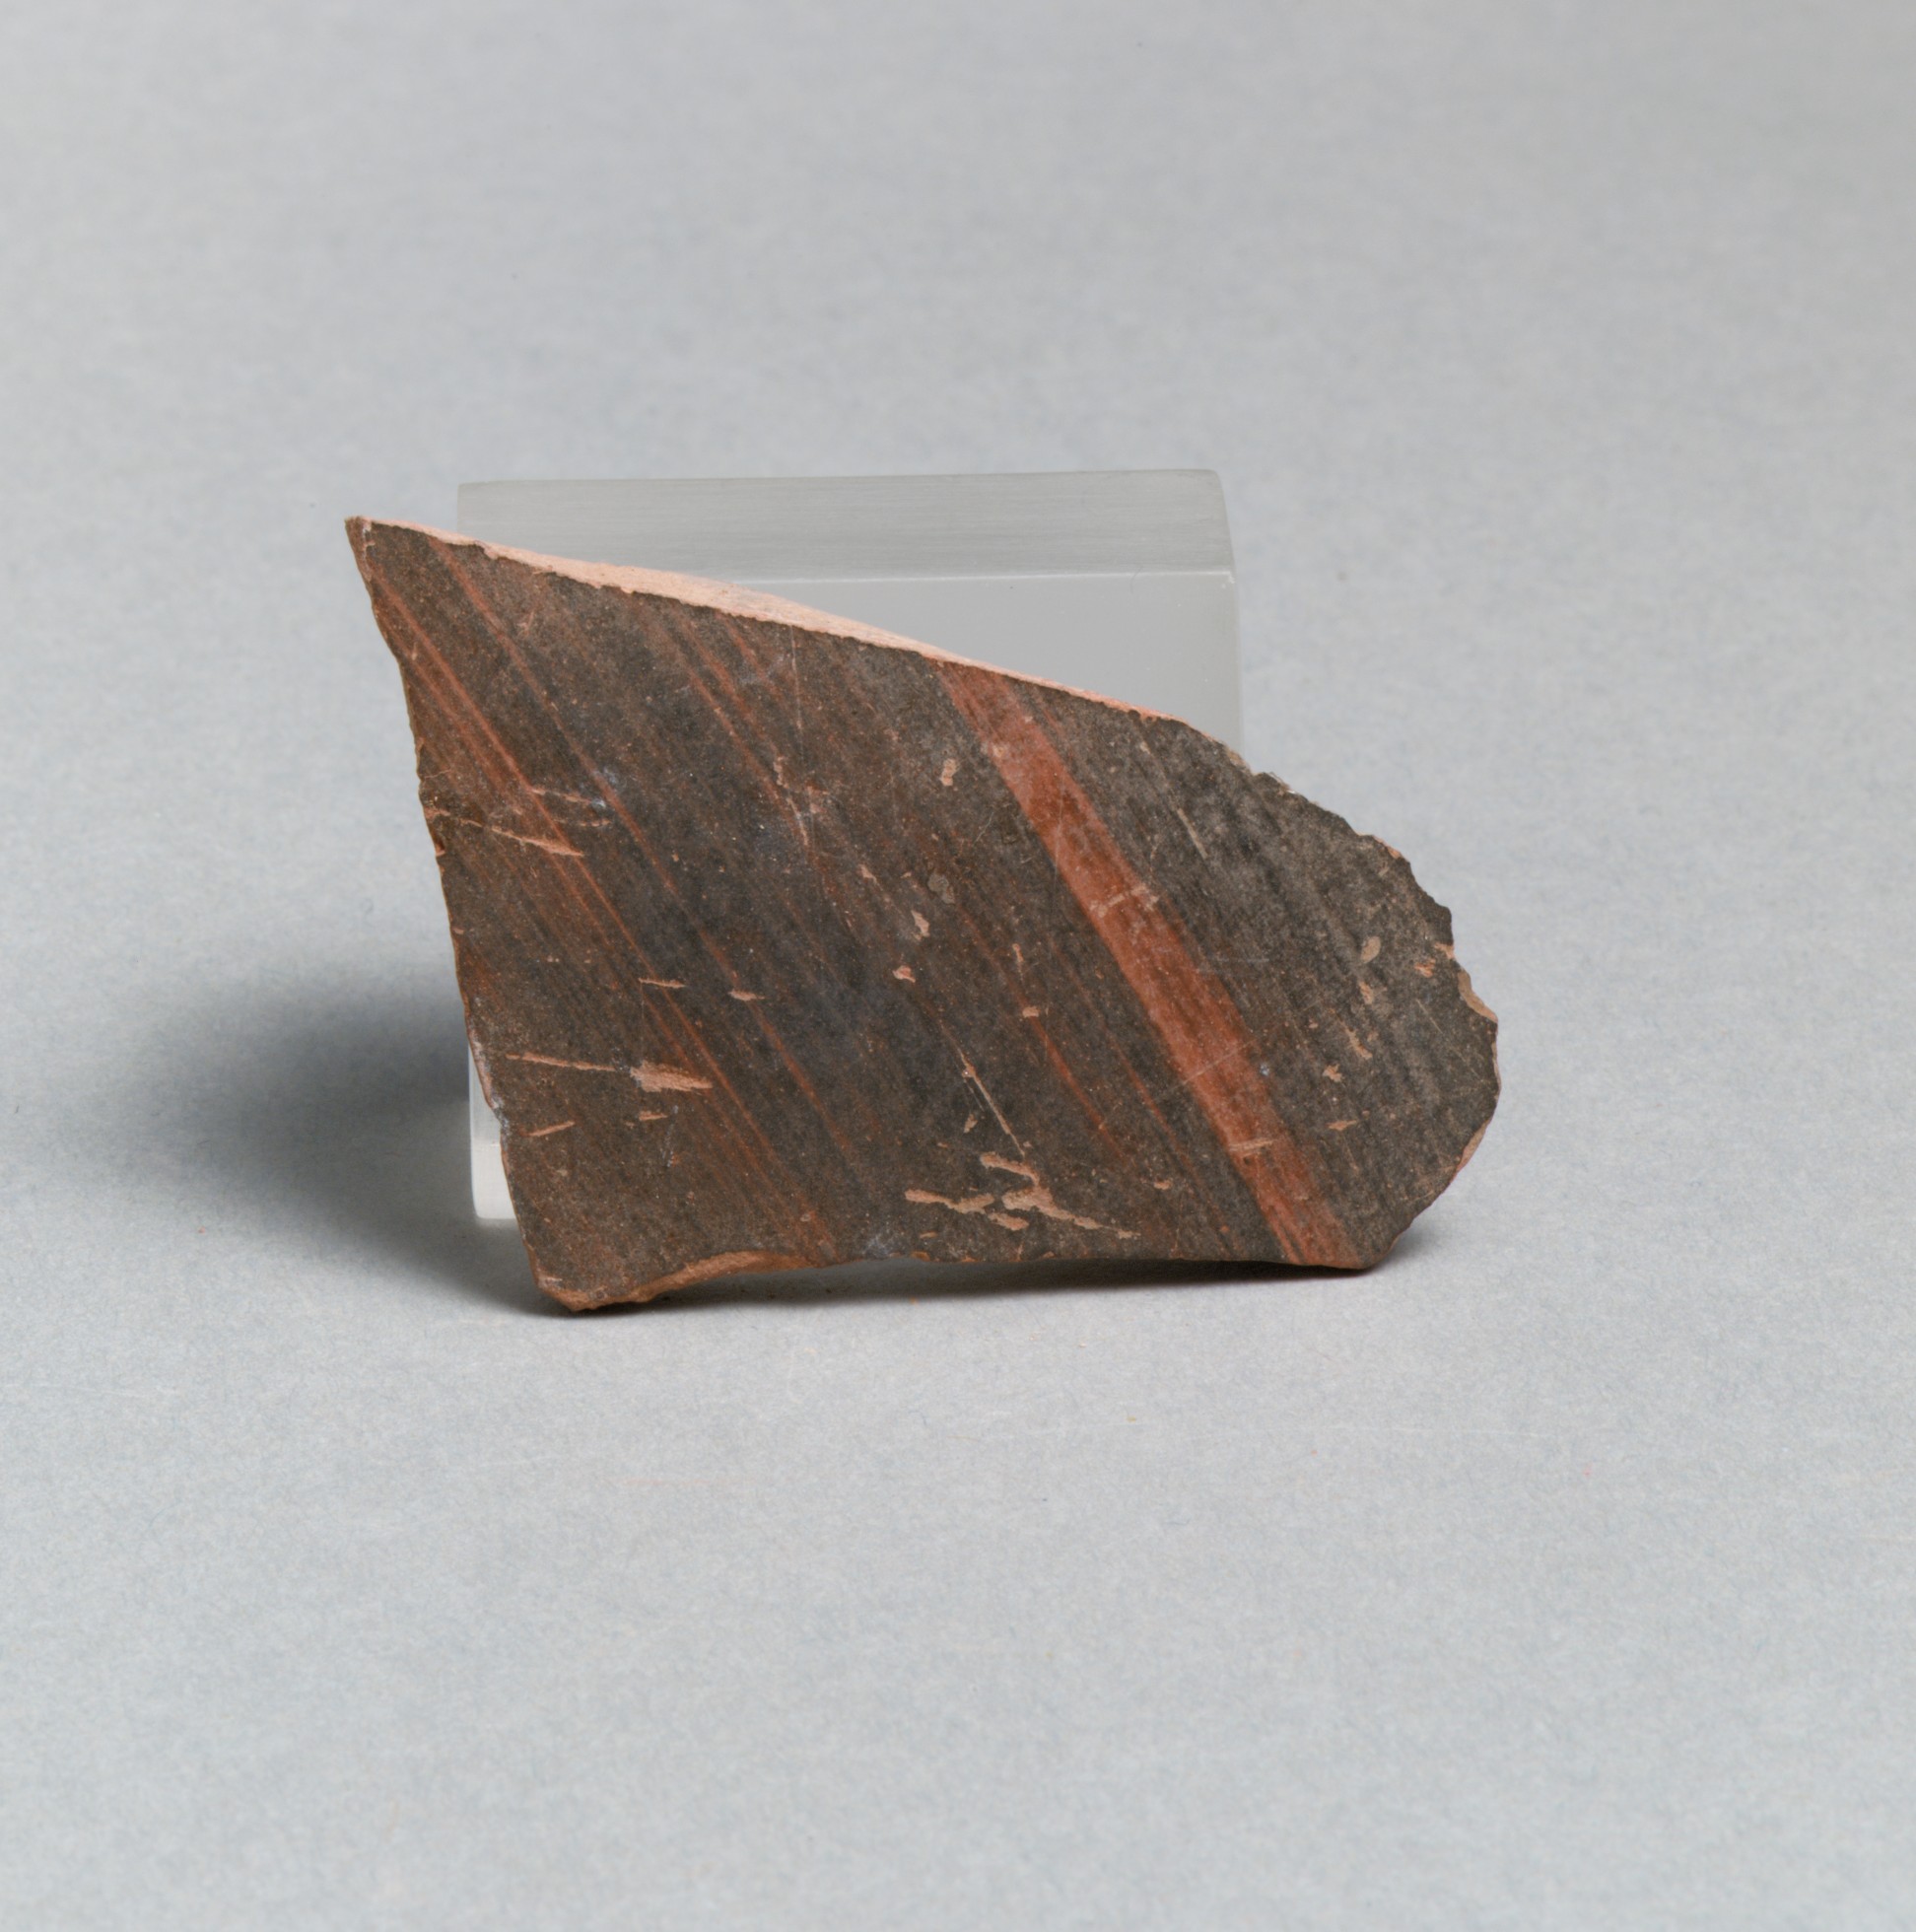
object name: vase fragment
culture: greek or lydian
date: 900-30 BCE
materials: terracotta